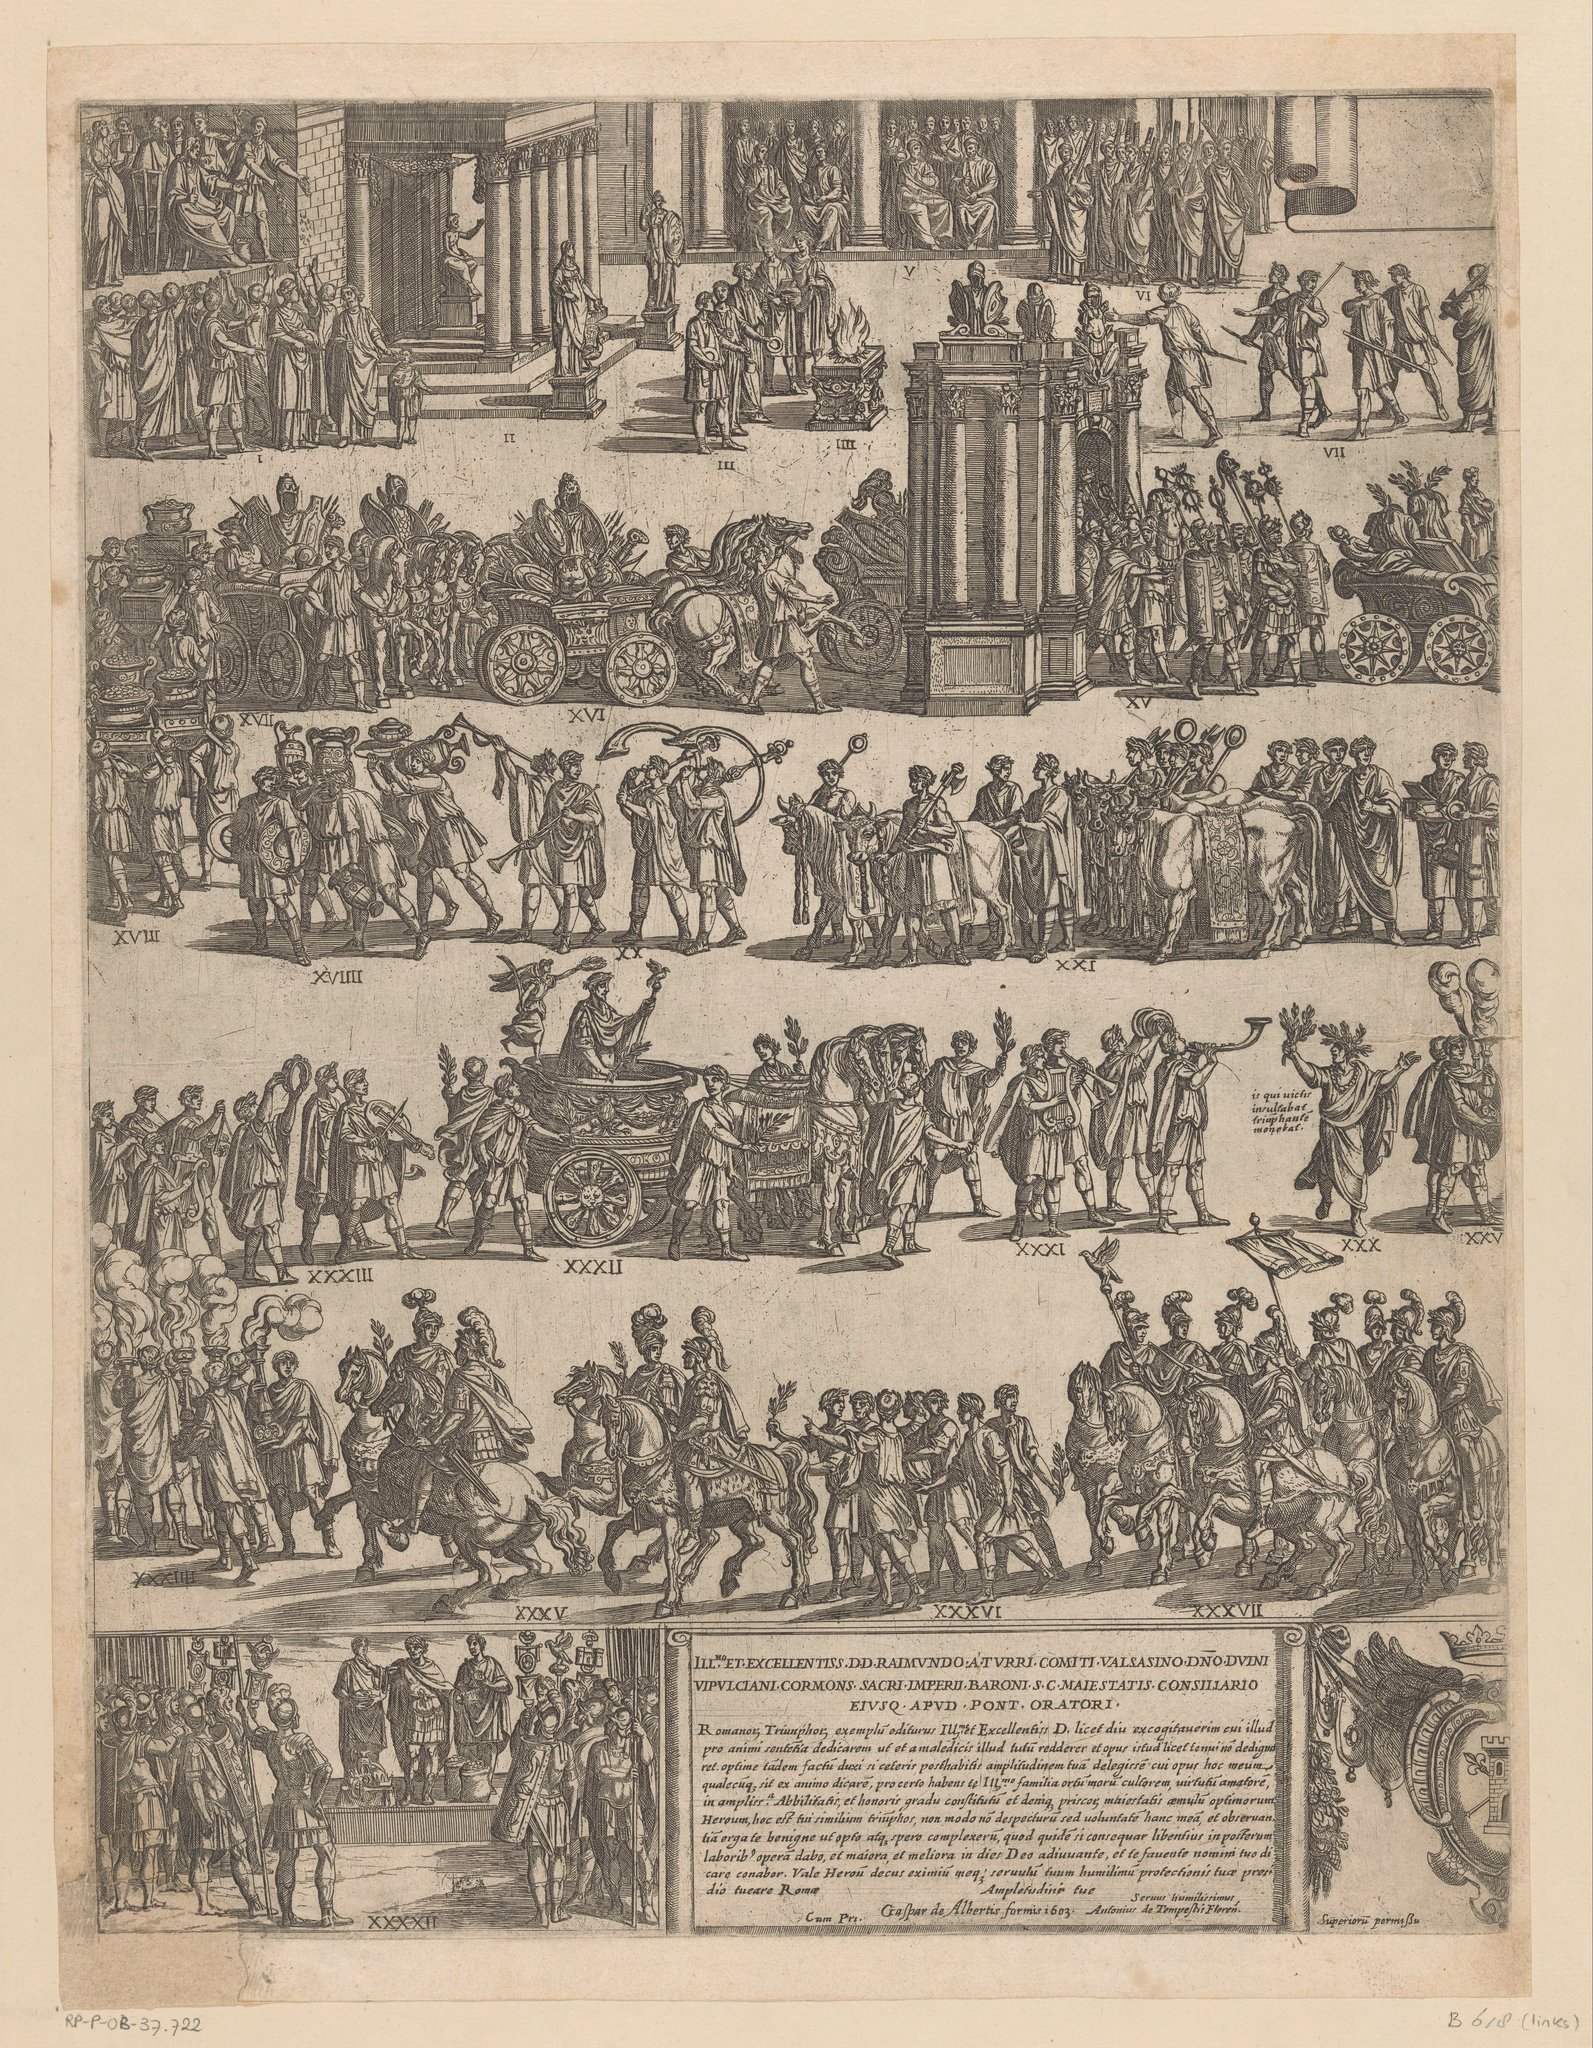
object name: print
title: Triomf van een Romeins keizer (linker deel)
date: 1603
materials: paper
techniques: etching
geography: rome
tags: triumphal arch, triumphal entry and public reception, pageant, 'entrée solennelle', 'joyeuse entrée', emperor, carrying off the spoils of war, division of the spoils of war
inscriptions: collector's mark: Lugt 240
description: Een triomftocht van een Romeins keizer. De stoet trekt van rechtsonder, onder twee triomfbogen door, naar een tempel linksboven. De stoet bestaat uit soldaten, gevangenen, olifanten, wagens vol oorlogsbuit en de keizer. Linksonder een voorstelling van de keizer die de oorlogsbuit verdeelt. Rechtsonder een voorstelling van een offerscène en een verklarende lijst met nummers.